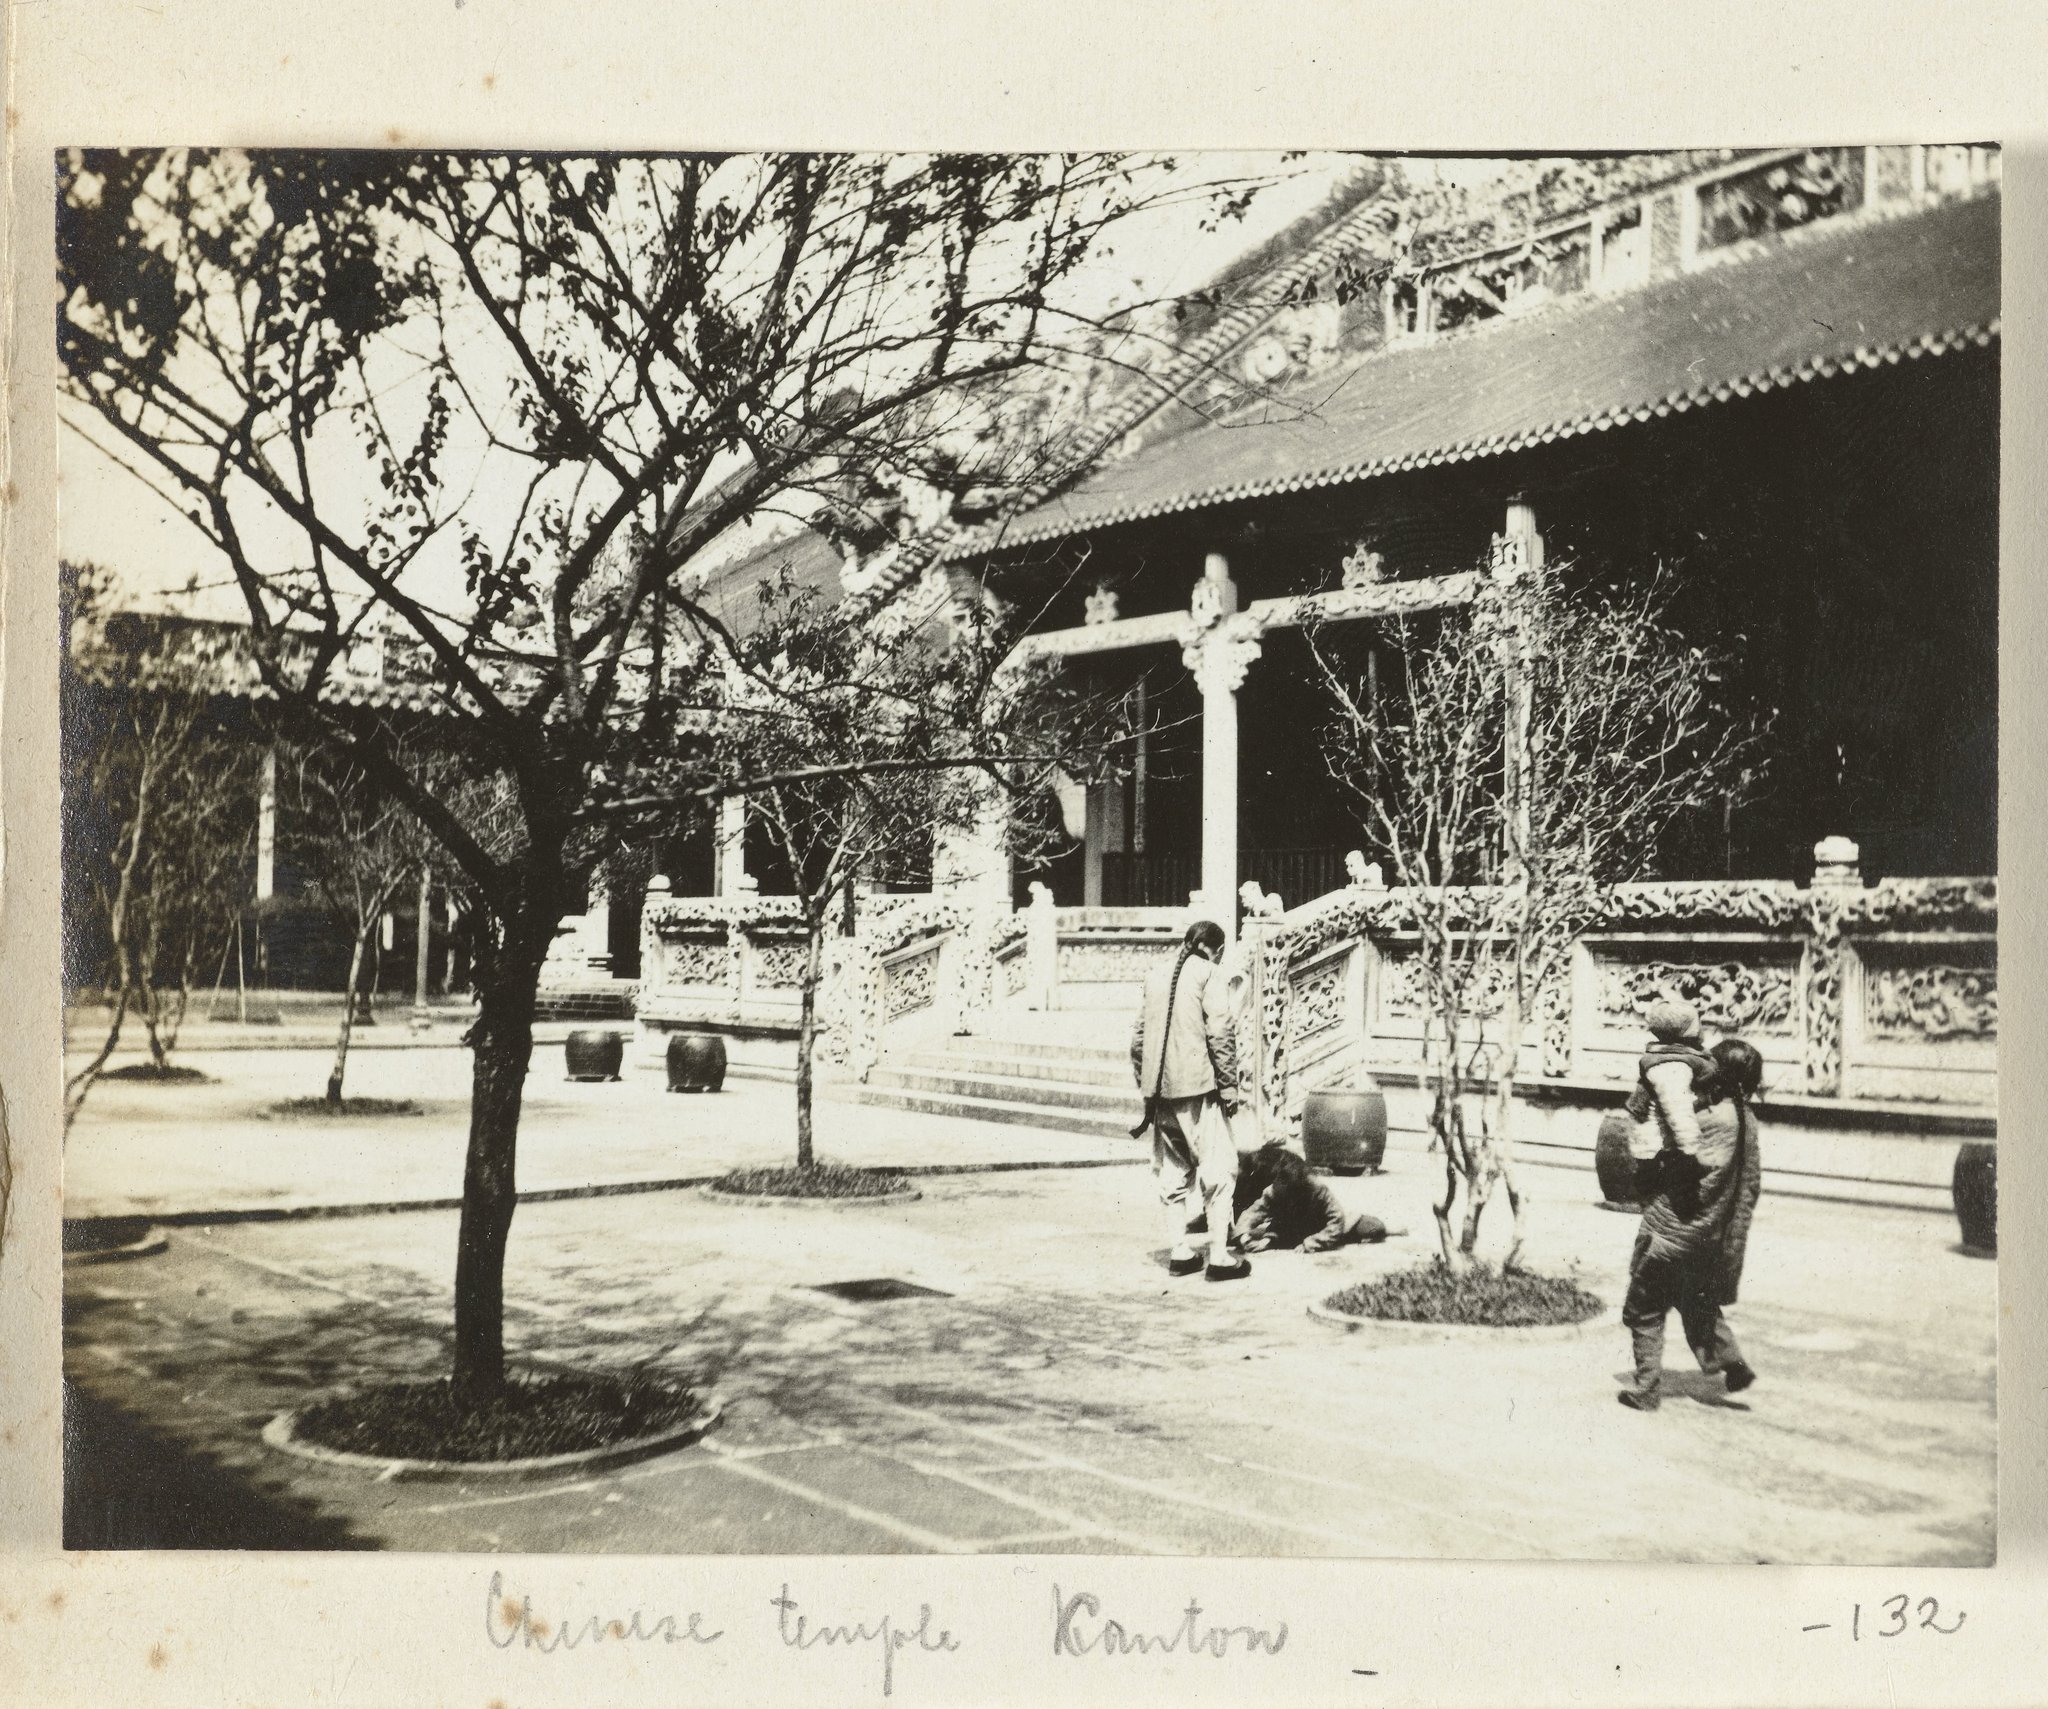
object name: photograph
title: Chinese temple Canton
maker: geldolph adriaan kessler (dolph)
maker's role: fotograaf, industrieel, voetballer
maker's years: 1884-1945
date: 1903-1908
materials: cardboard, photographic support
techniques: gelatin silver print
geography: guangdong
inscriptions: title: ‘Chinese temple Canton’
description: Boeddhistisch tempelcomplex in Kanton. Onderdeel van het fotoalbum van Dolph Kessler met opnamen die hij maakte tijdens zijn verblijf in Engeland en op een wereldreis die hij als secretaris van Henri Deterding (directeur Koninklijke Olie) ondernam naar Nederlands-Indië, Japan, China en de Verenigde Staten, tussen 1906 en 1908.